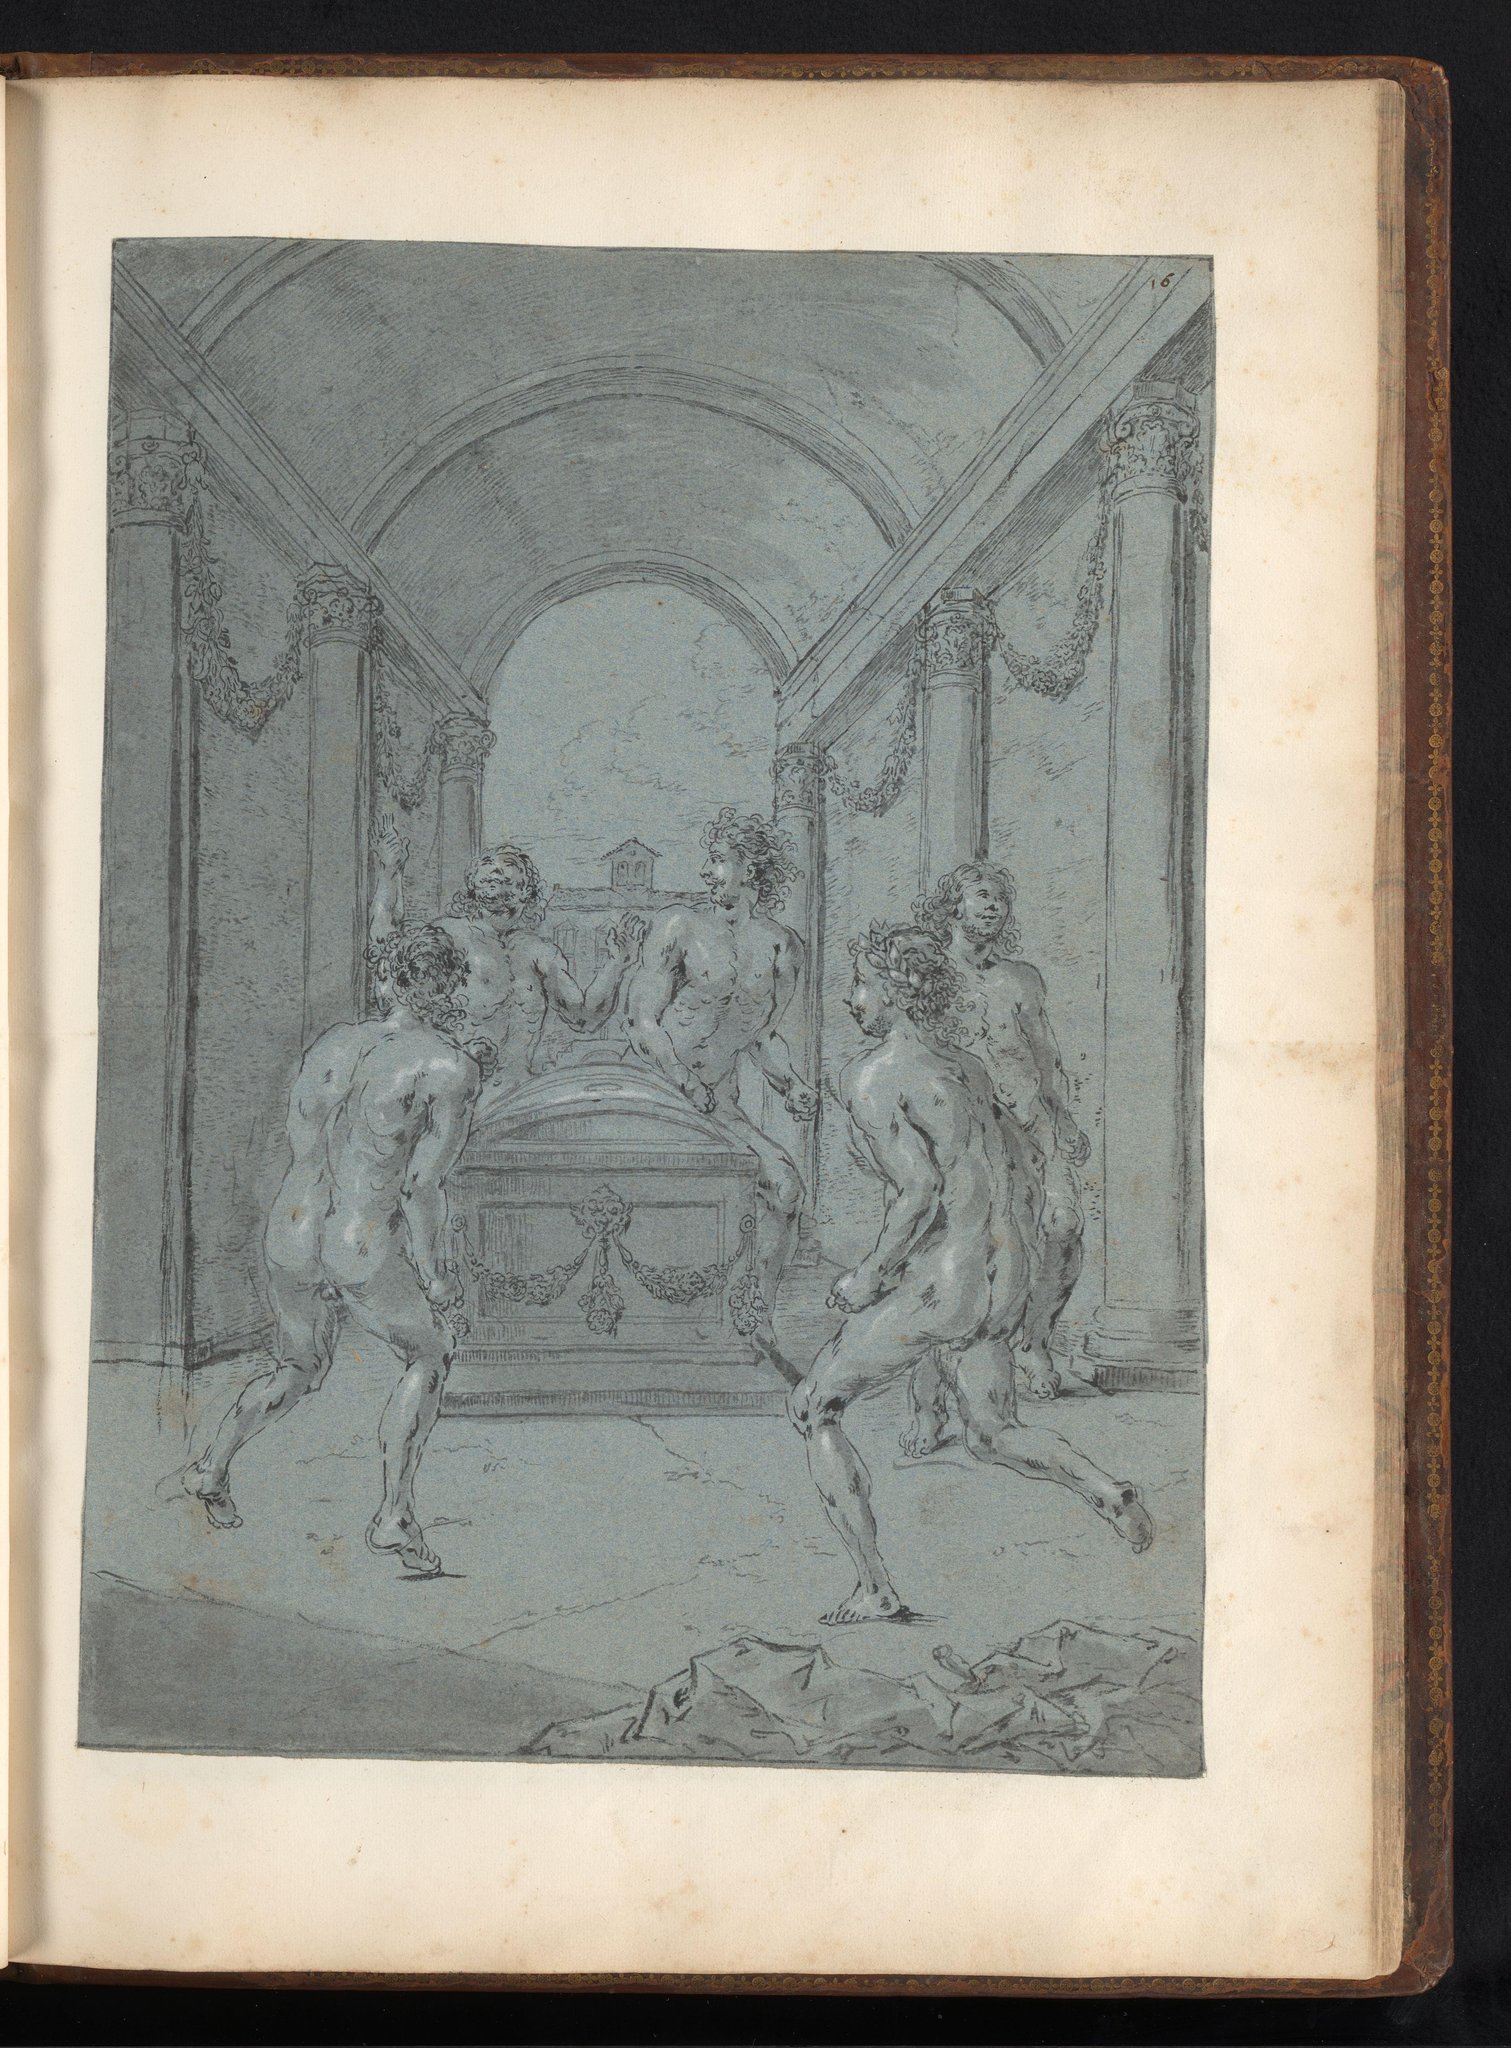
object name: album leaf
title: Loopt met sijn hovelinge naackt om het graf van Achillis, dat rontom met festons van blomen is behangen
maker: leonaert bramer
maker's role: draughtsman, painter, print maker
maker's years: 1596-1674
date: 1655-1665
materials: paint, ink, paper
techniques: brush, pen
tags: alexander at the tomb of achilles; either sacrificing and laying flowers, or listening to the iliad being recited, (story of) achilles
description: Alexander de Grote en zijn hovelingen dansen, volgens oud gebruik, naakt om het graf van Achilles. Rechtsboven genummerd: 16. Tekening maakt deel uit van een album.